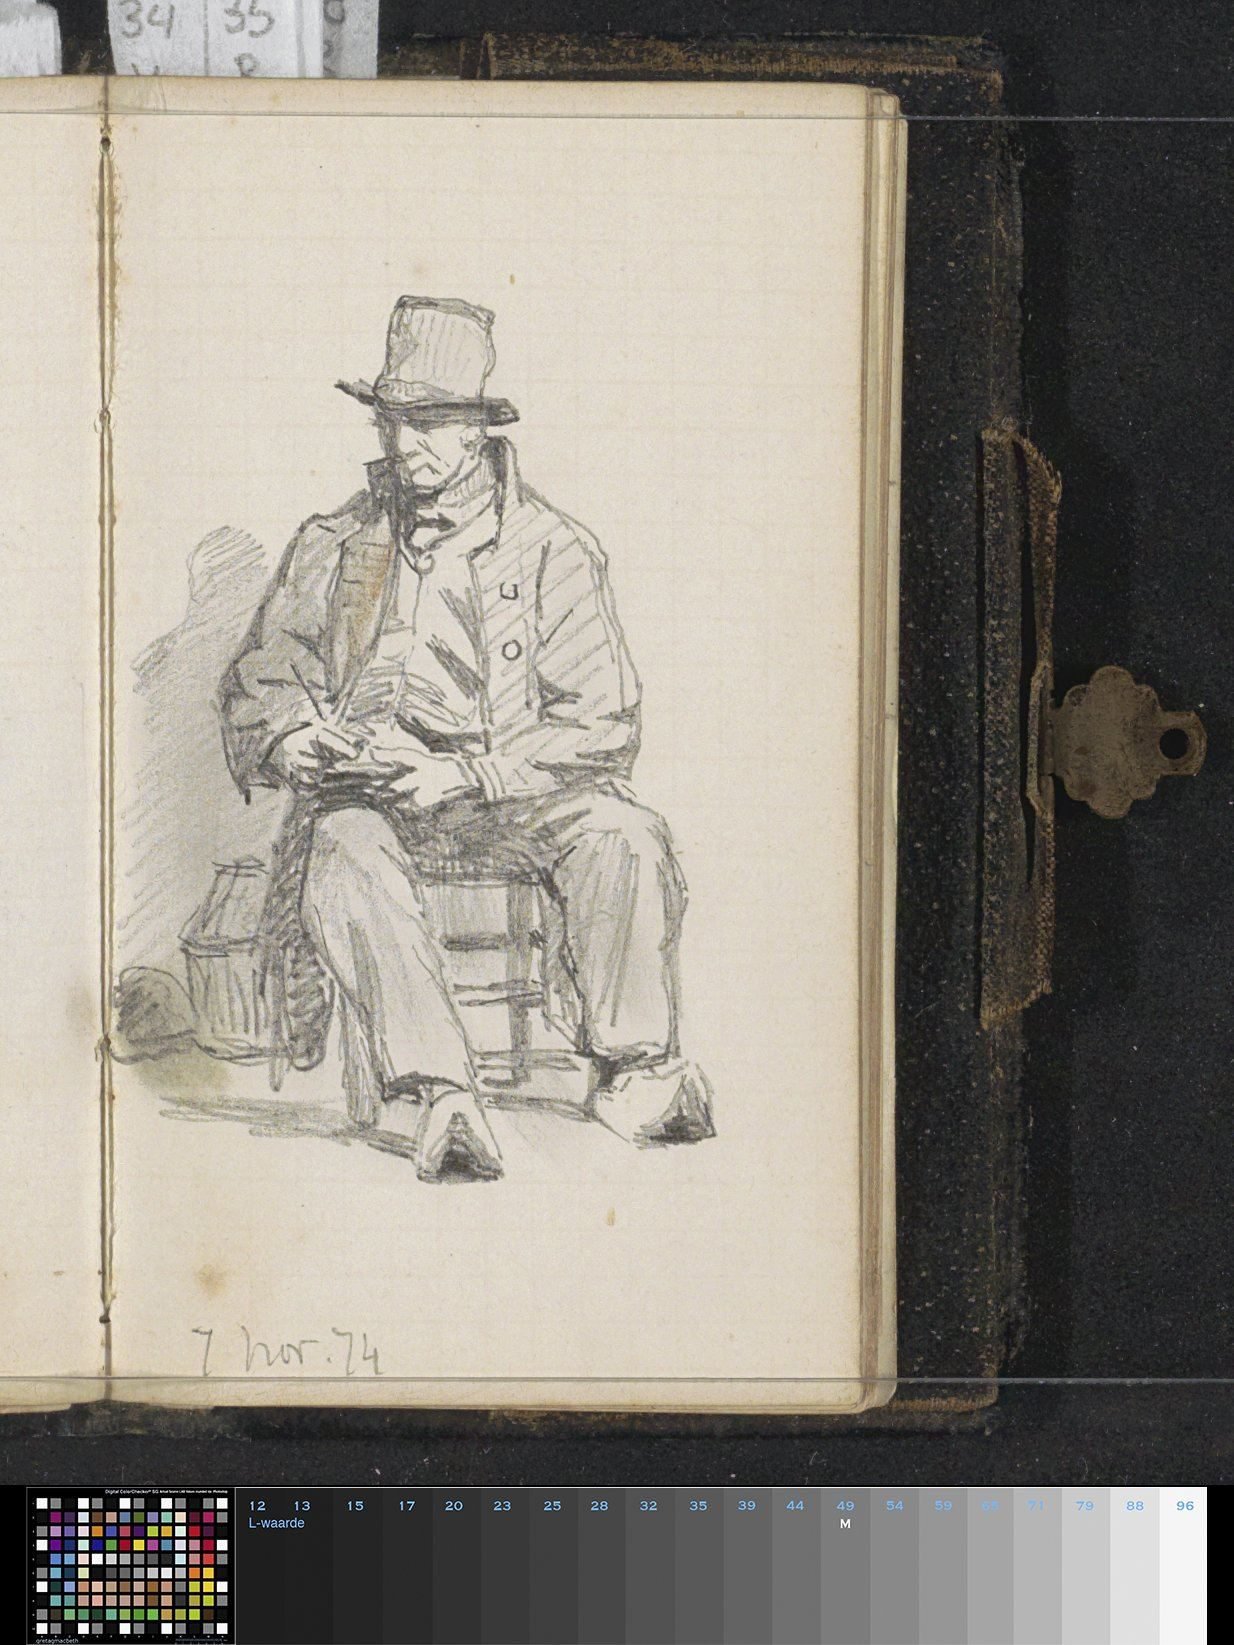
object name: sketchbook leaf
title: Schrijvende man zittend op een stoel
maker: jan willem van borselen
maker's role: draughtsman, print maker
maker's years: 1825-1892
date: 1811-1874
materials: pencil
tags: sitting figure, writing and letters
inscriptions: date: ‘7 nov. 74’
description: De man draagt klompen en een hoge hoed. Blad 31 recto uit een schetsboek met 51 bladen.